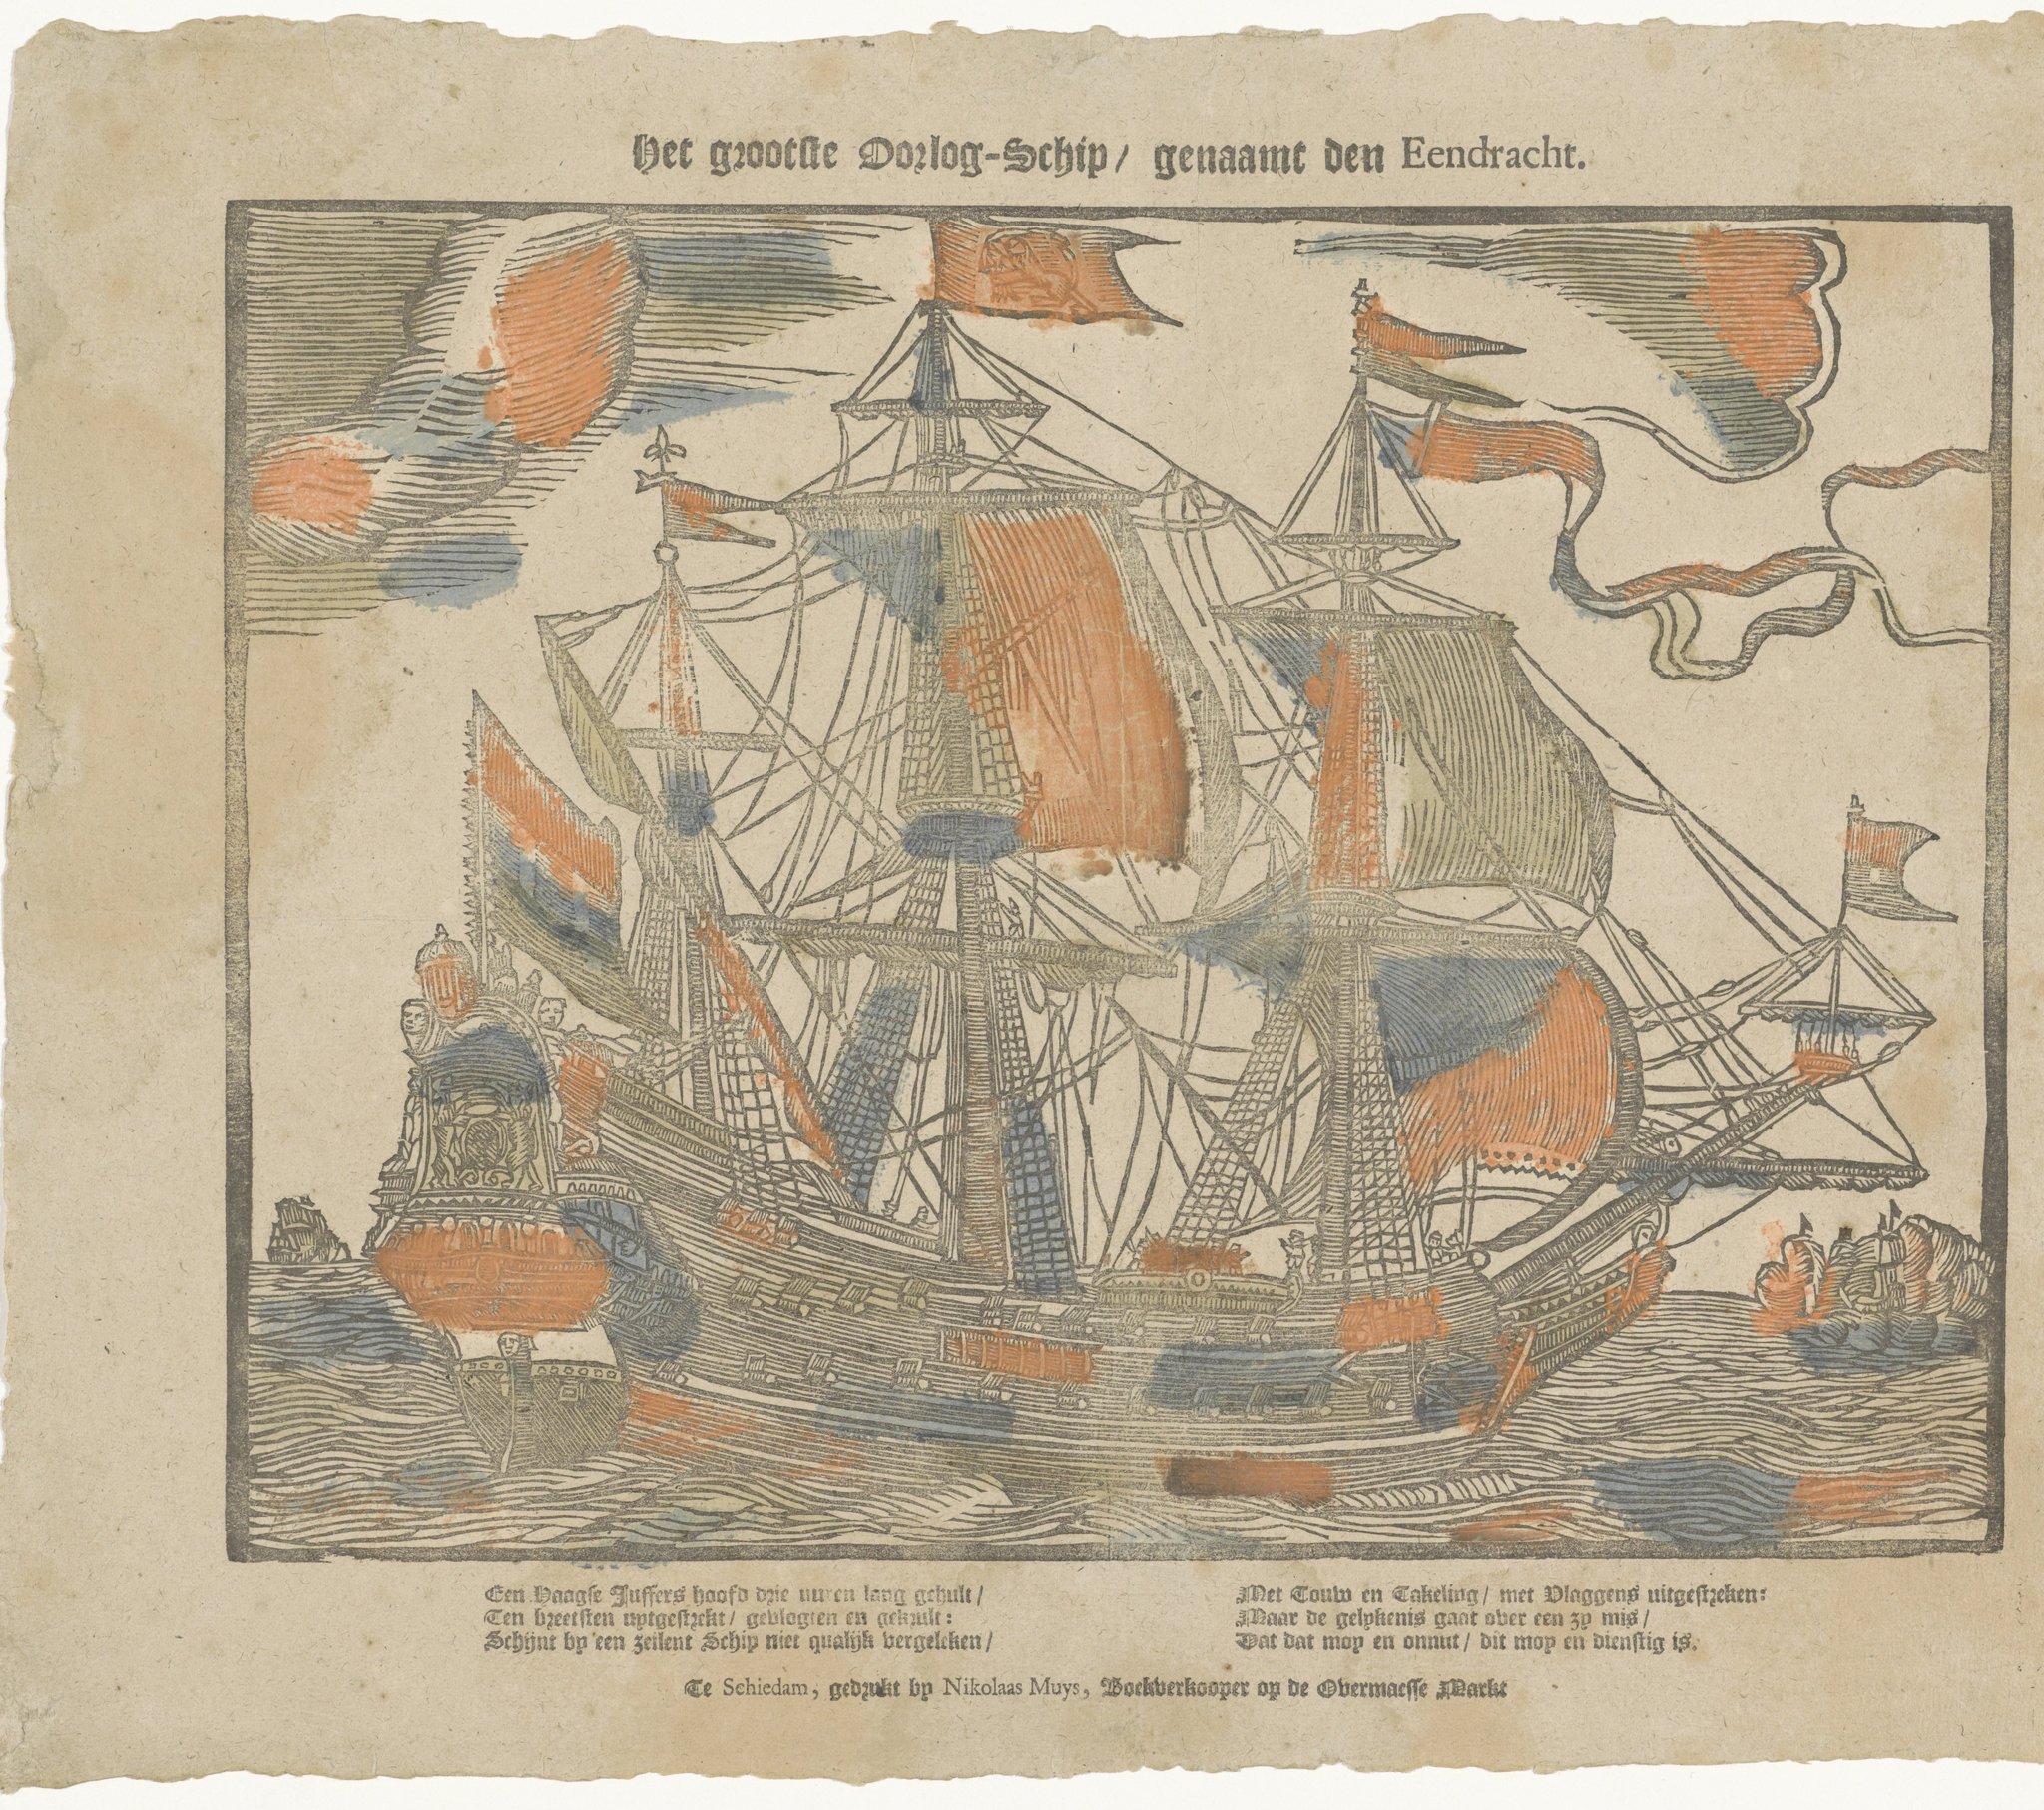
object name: print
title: Het grootste Oorlogs-schip / genaamt den Eendracht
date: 1704-1757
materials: paper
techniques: colour, letterpress printing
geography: schiedam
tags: military vehicles (+ sailing-ships)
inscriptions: collector's mark: Lugt 2228, collector's mark: Lugt 2760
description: Blad met een grote voorstelling van een Hollands oorlogsschip op zee. Onder de afbeelding een zesregelig vers.